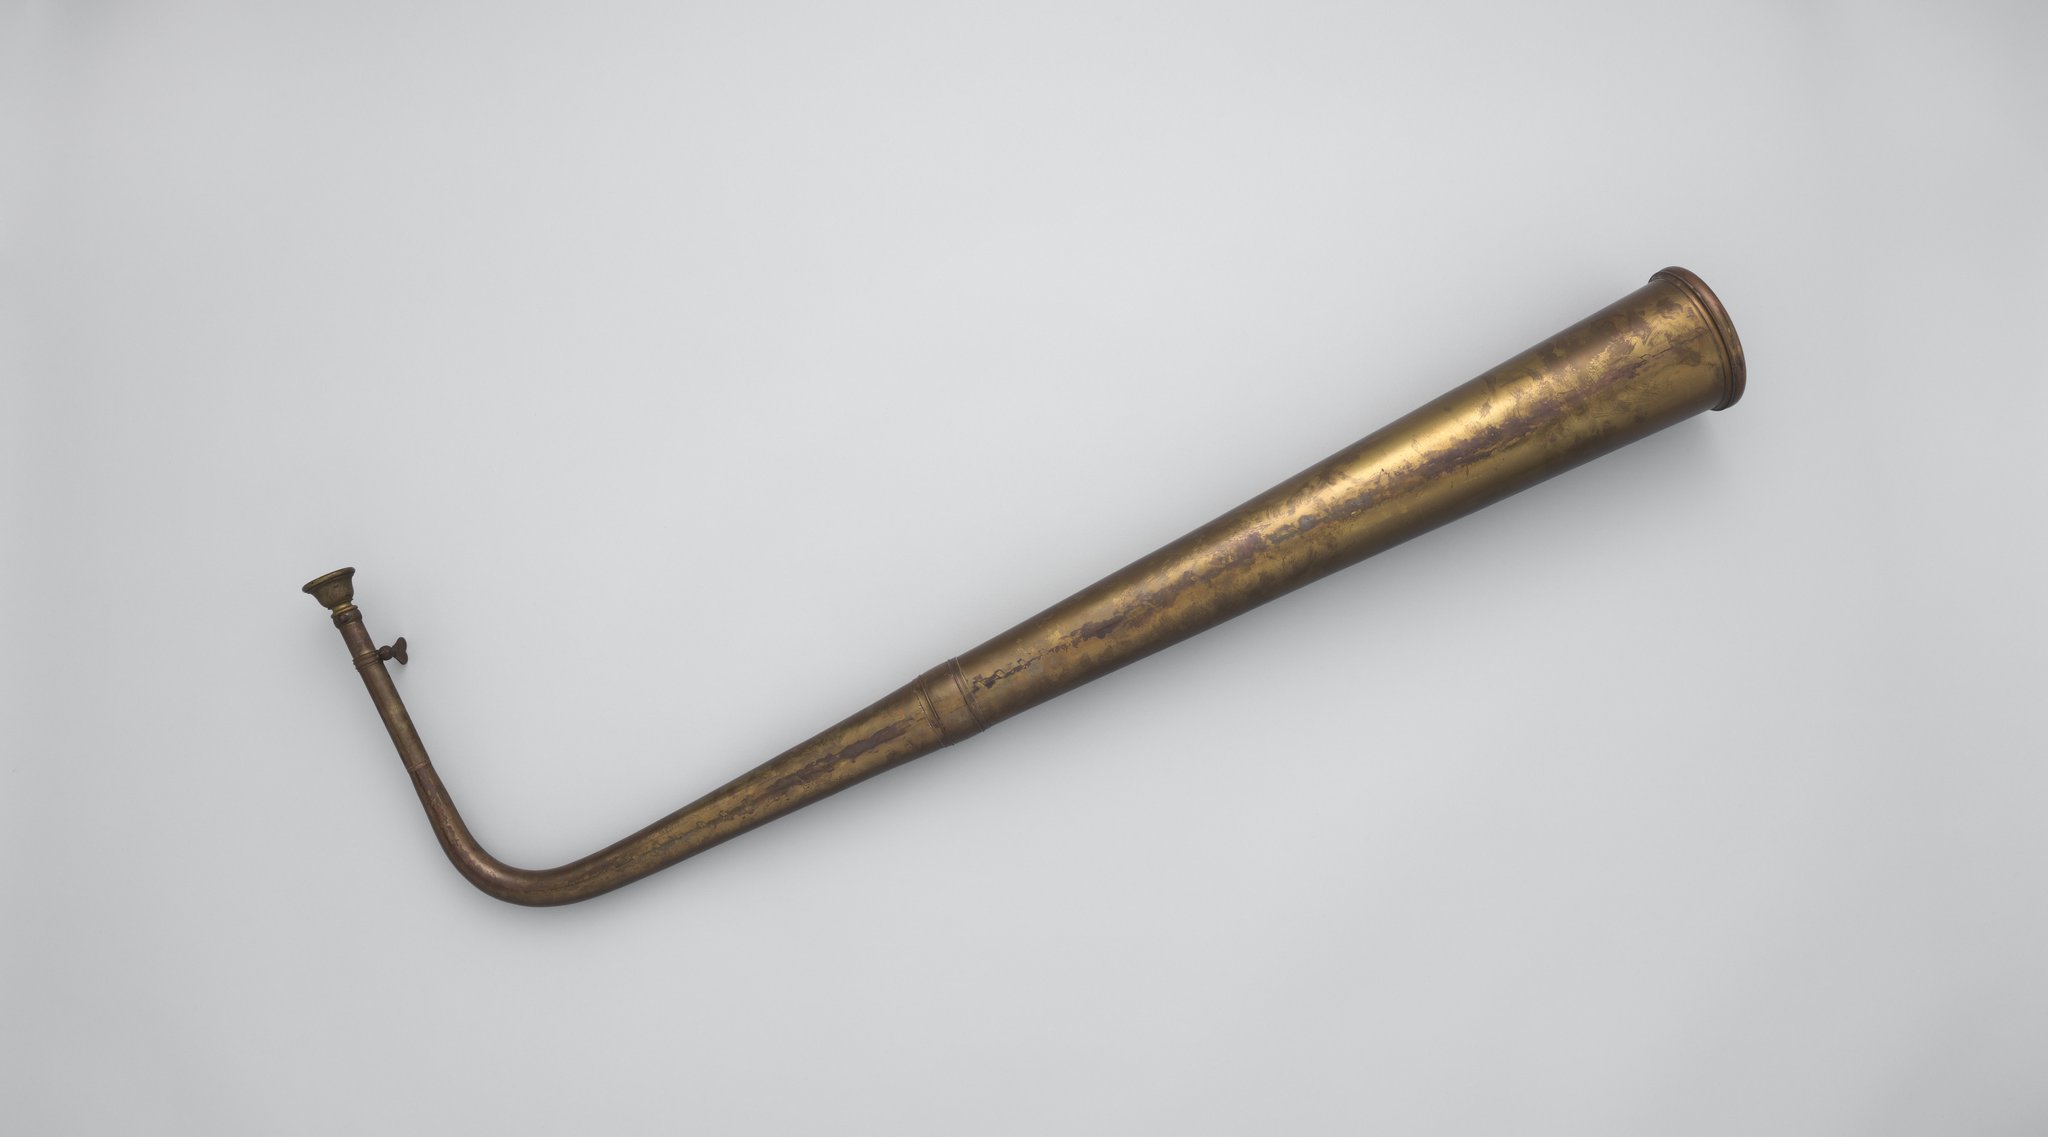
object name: ohotniche rogi sounding a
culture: russian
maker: n. n. federov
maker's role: maker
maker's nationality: russian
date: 1873-1889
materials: brass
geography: russia